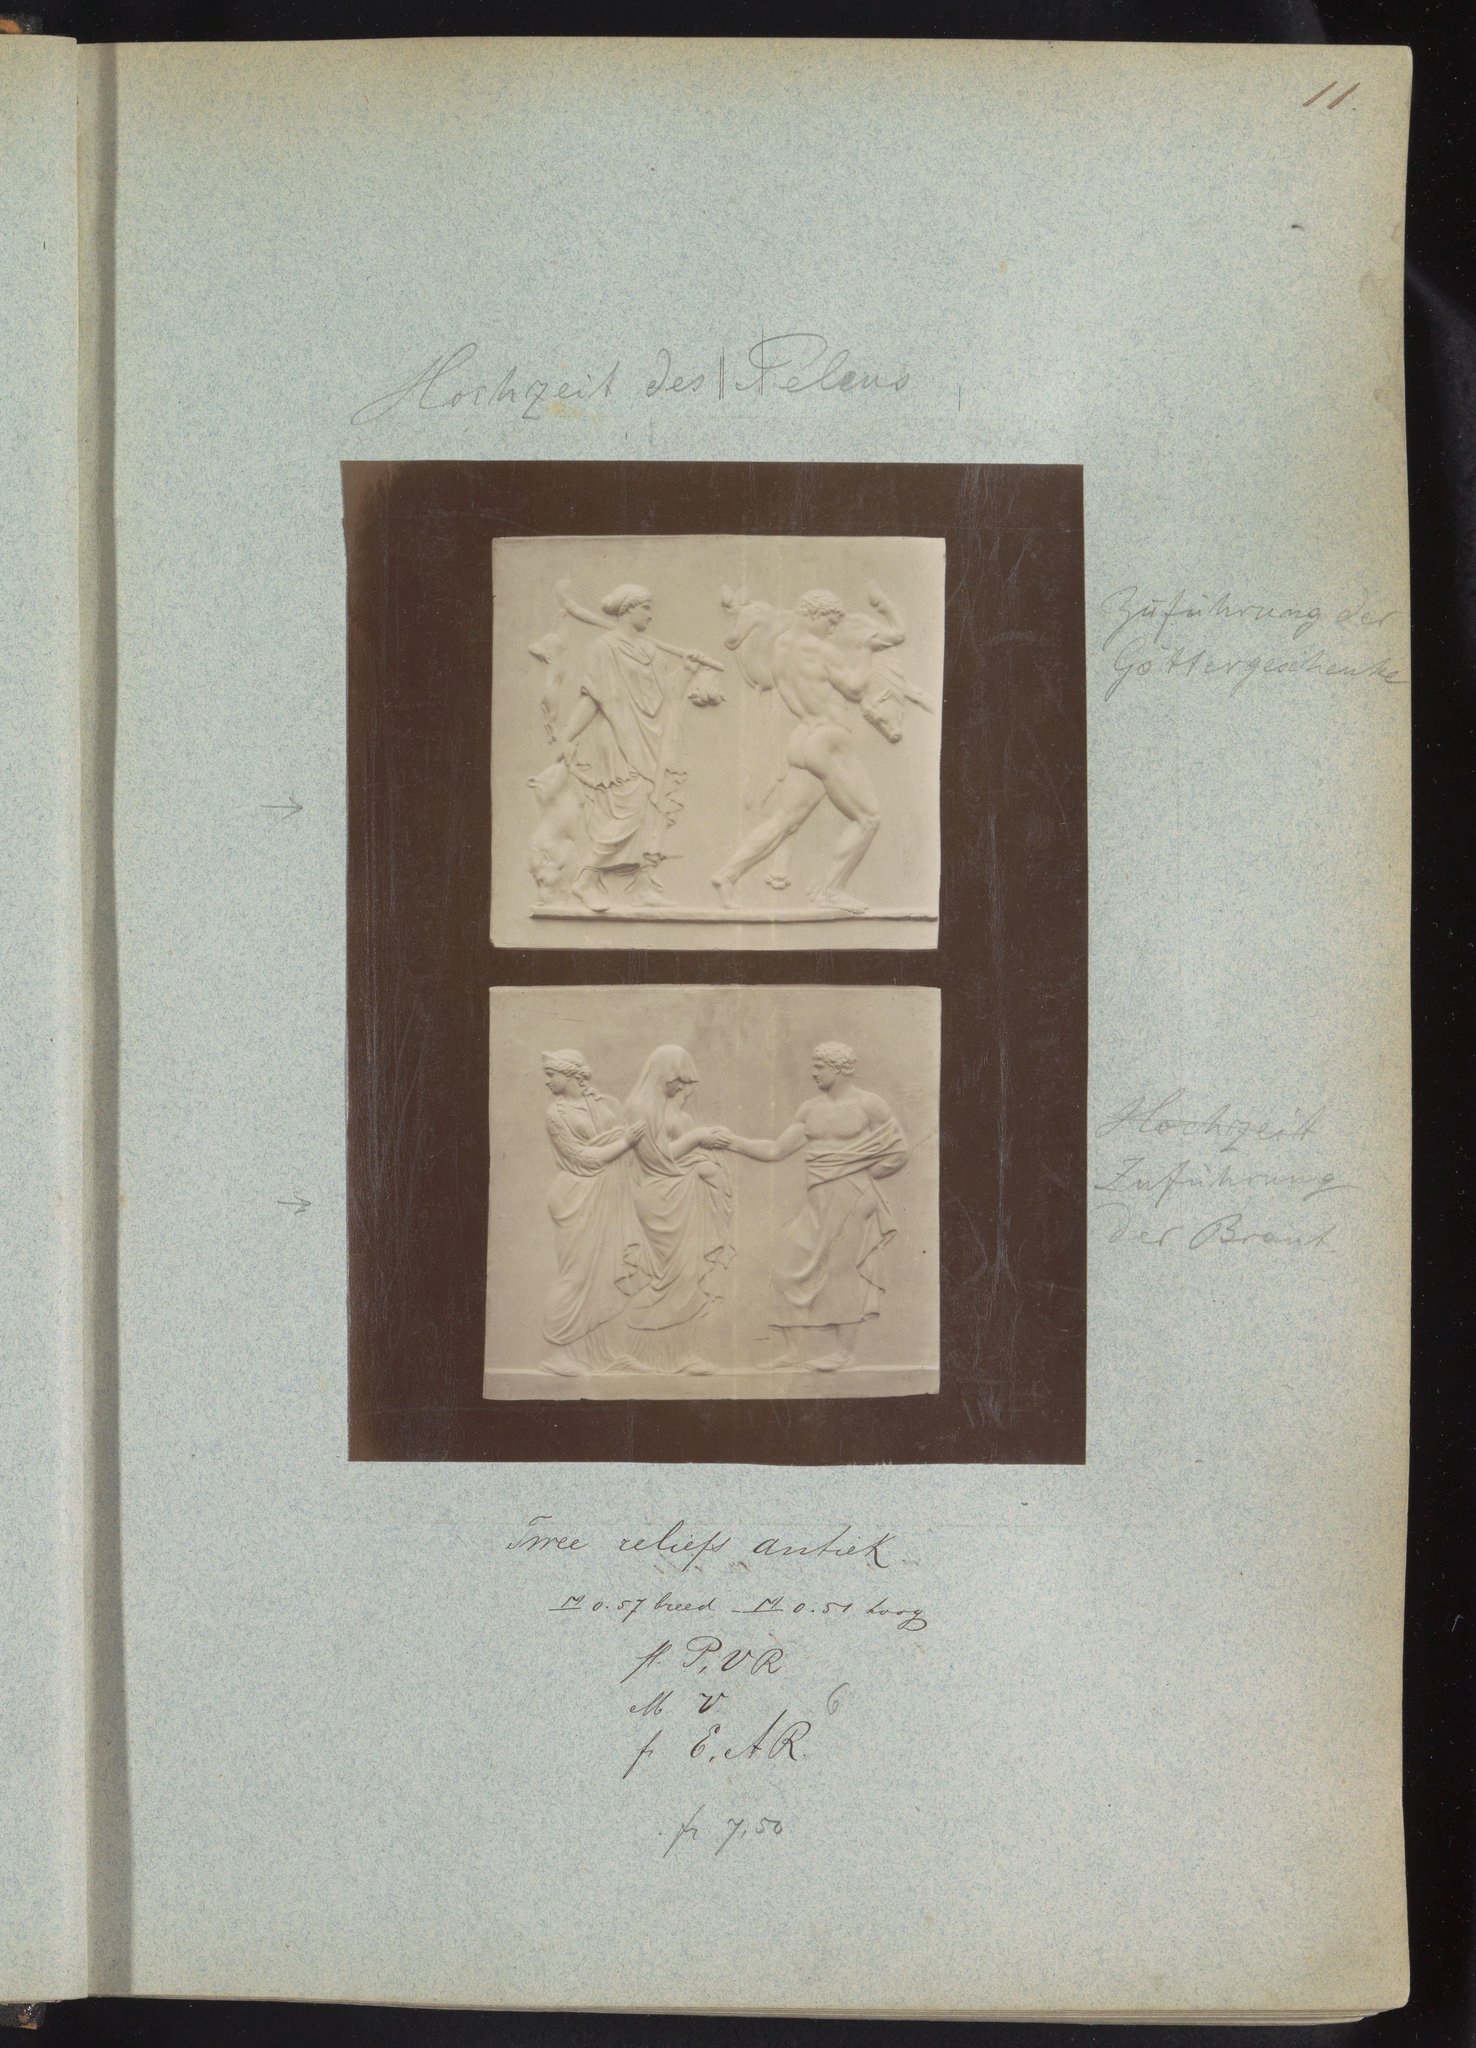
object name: album leaf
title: Twee antieke reliëfs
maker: Anonymous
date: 1875-1900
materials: paper, photographic support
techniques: albumen print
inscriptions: annotation, annotation: ‘Hochzeit des Peleus / Zuführung der Gottes Geschenke / Zuführung der Braut / Twee reliëfs antiek / M 0.57 breed M 0.51 hoog’